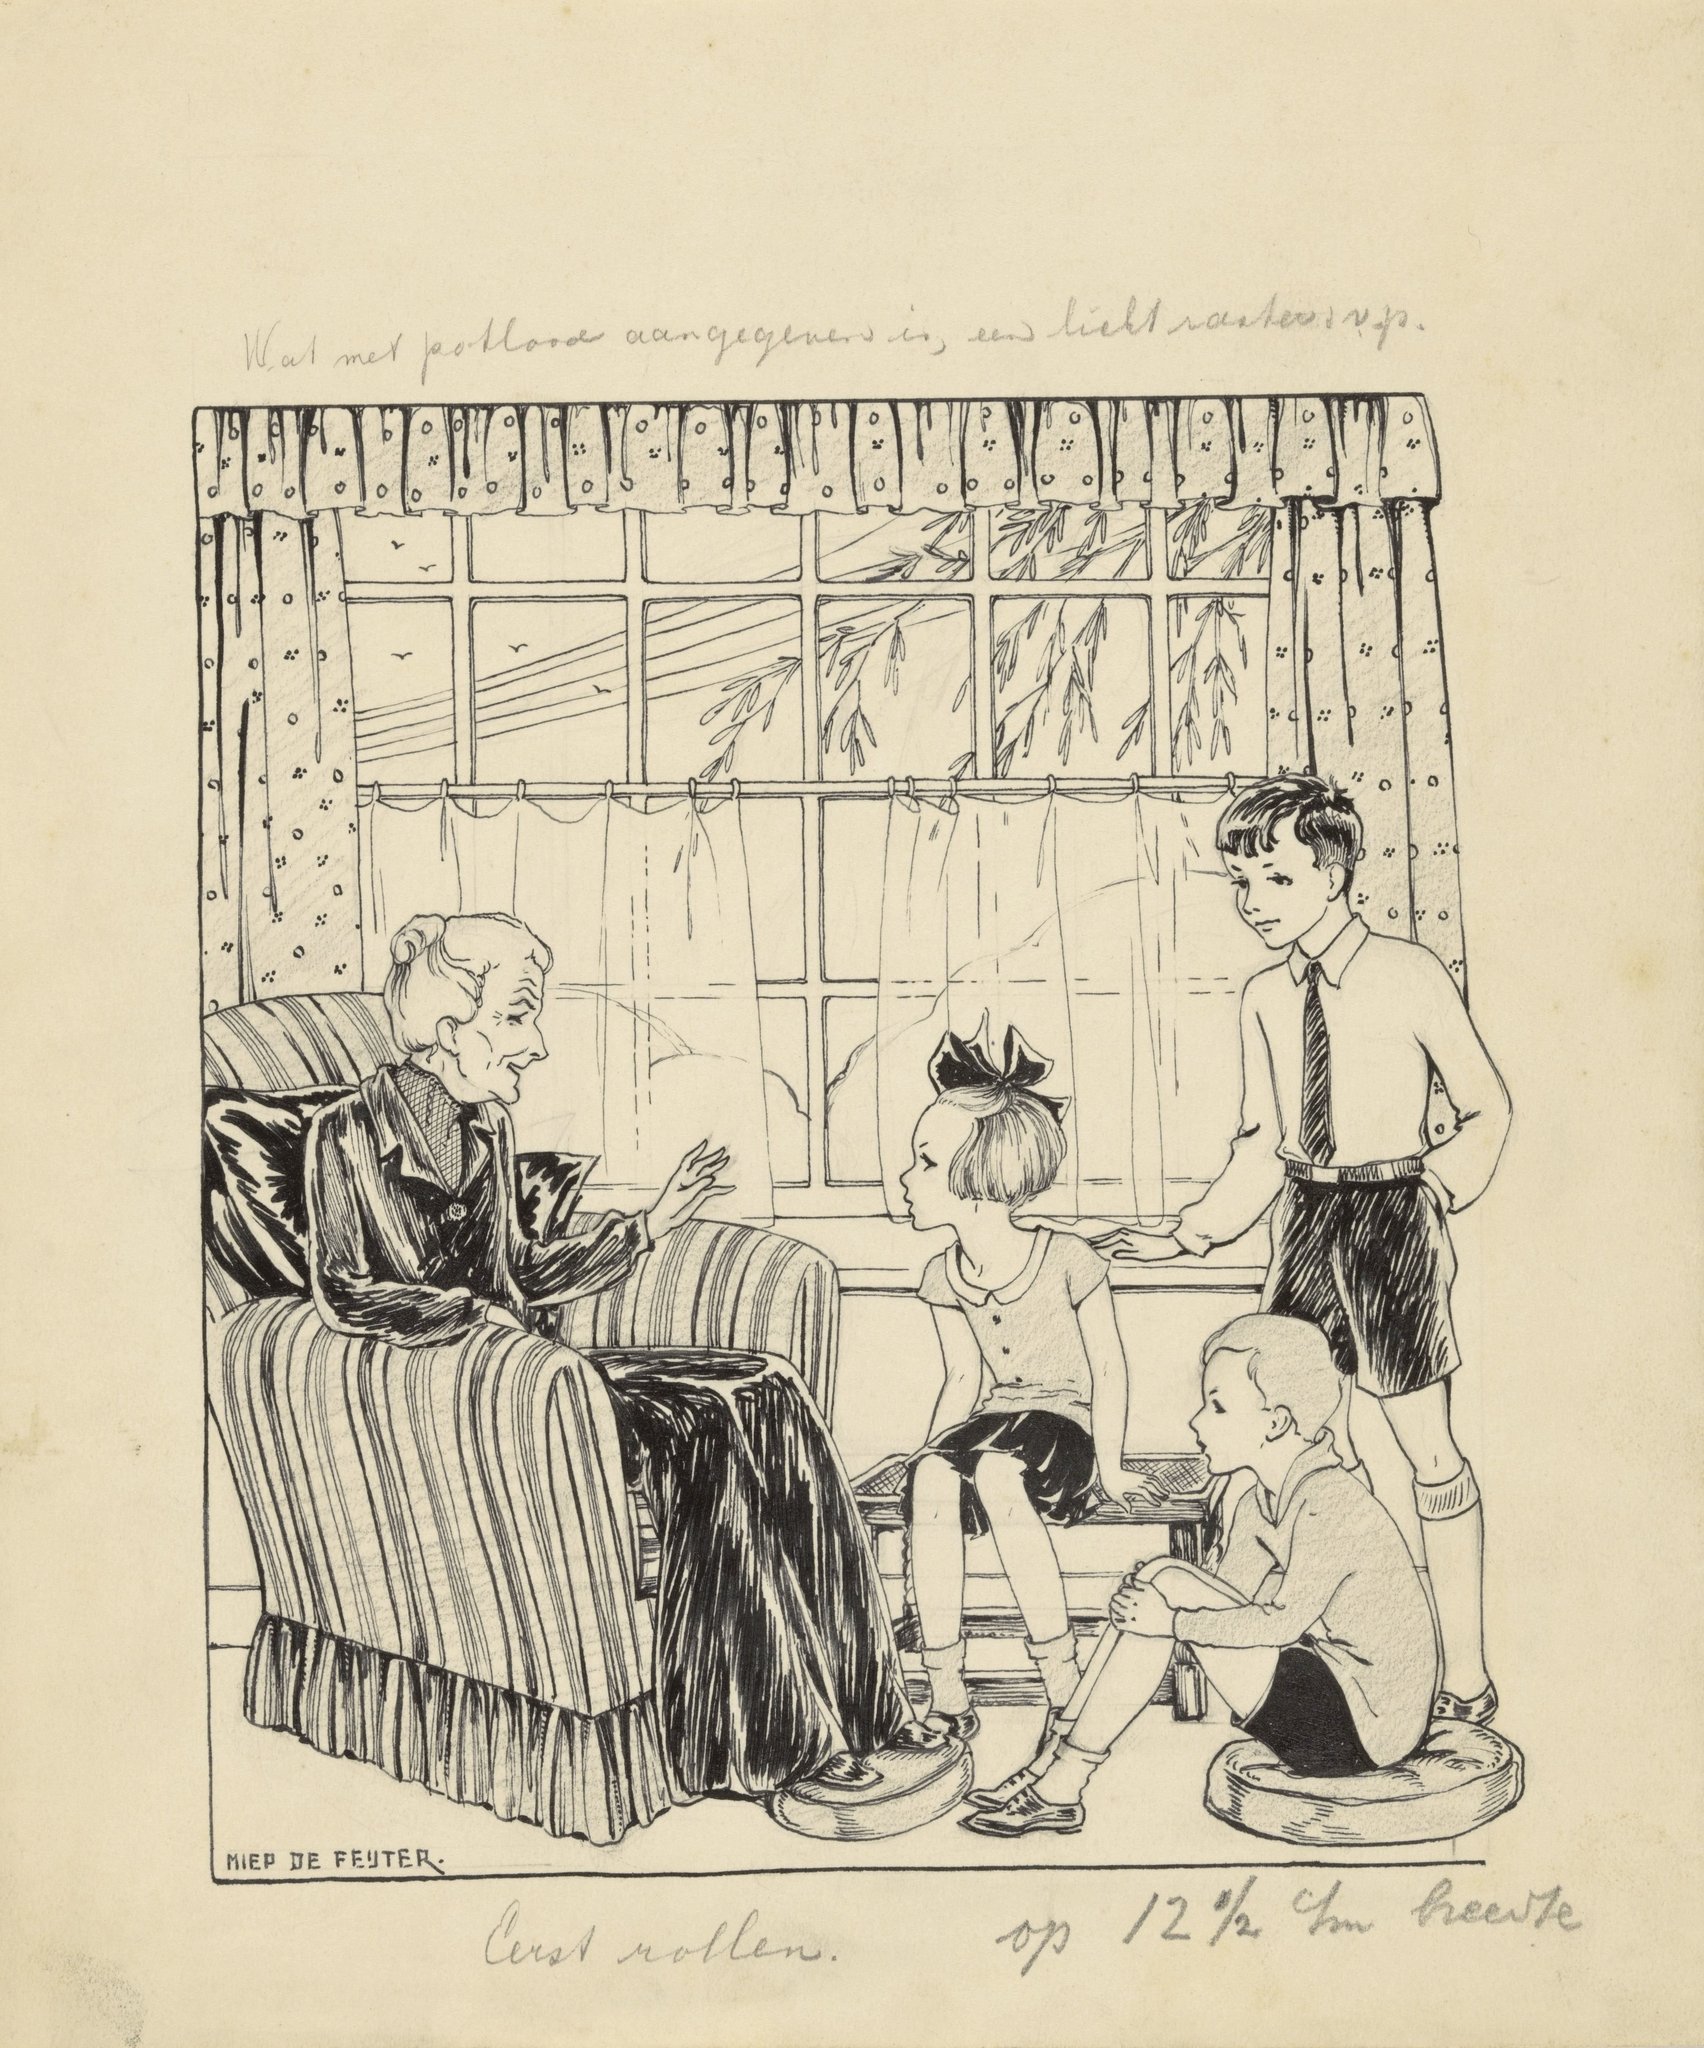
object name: boekillustratie ontwerp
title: Interieur met een oude vrouw en drie kinderen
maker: miep de feijter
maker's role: draughtsman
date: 1928-1941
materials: ink, paper, pencil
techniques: brush, pen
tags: armchair, seat, sitting figure (+ old female (human being)), child, interior of the house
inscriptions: signature: ‘MIEP DE FEIJTER.’, collector's mark: Lugt 2228a, annotation: ‘Eerst rollen.’, :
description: In een interieur zit een oude vrouw met opgeheven hand in een leunstoel bij een venster. Naast haar zit een meisje op een tafel en een jongen op een kussen op de grond. Een tweede jongen staat bij de vensterbank. De drie kinderen kijken naar de vrouw.